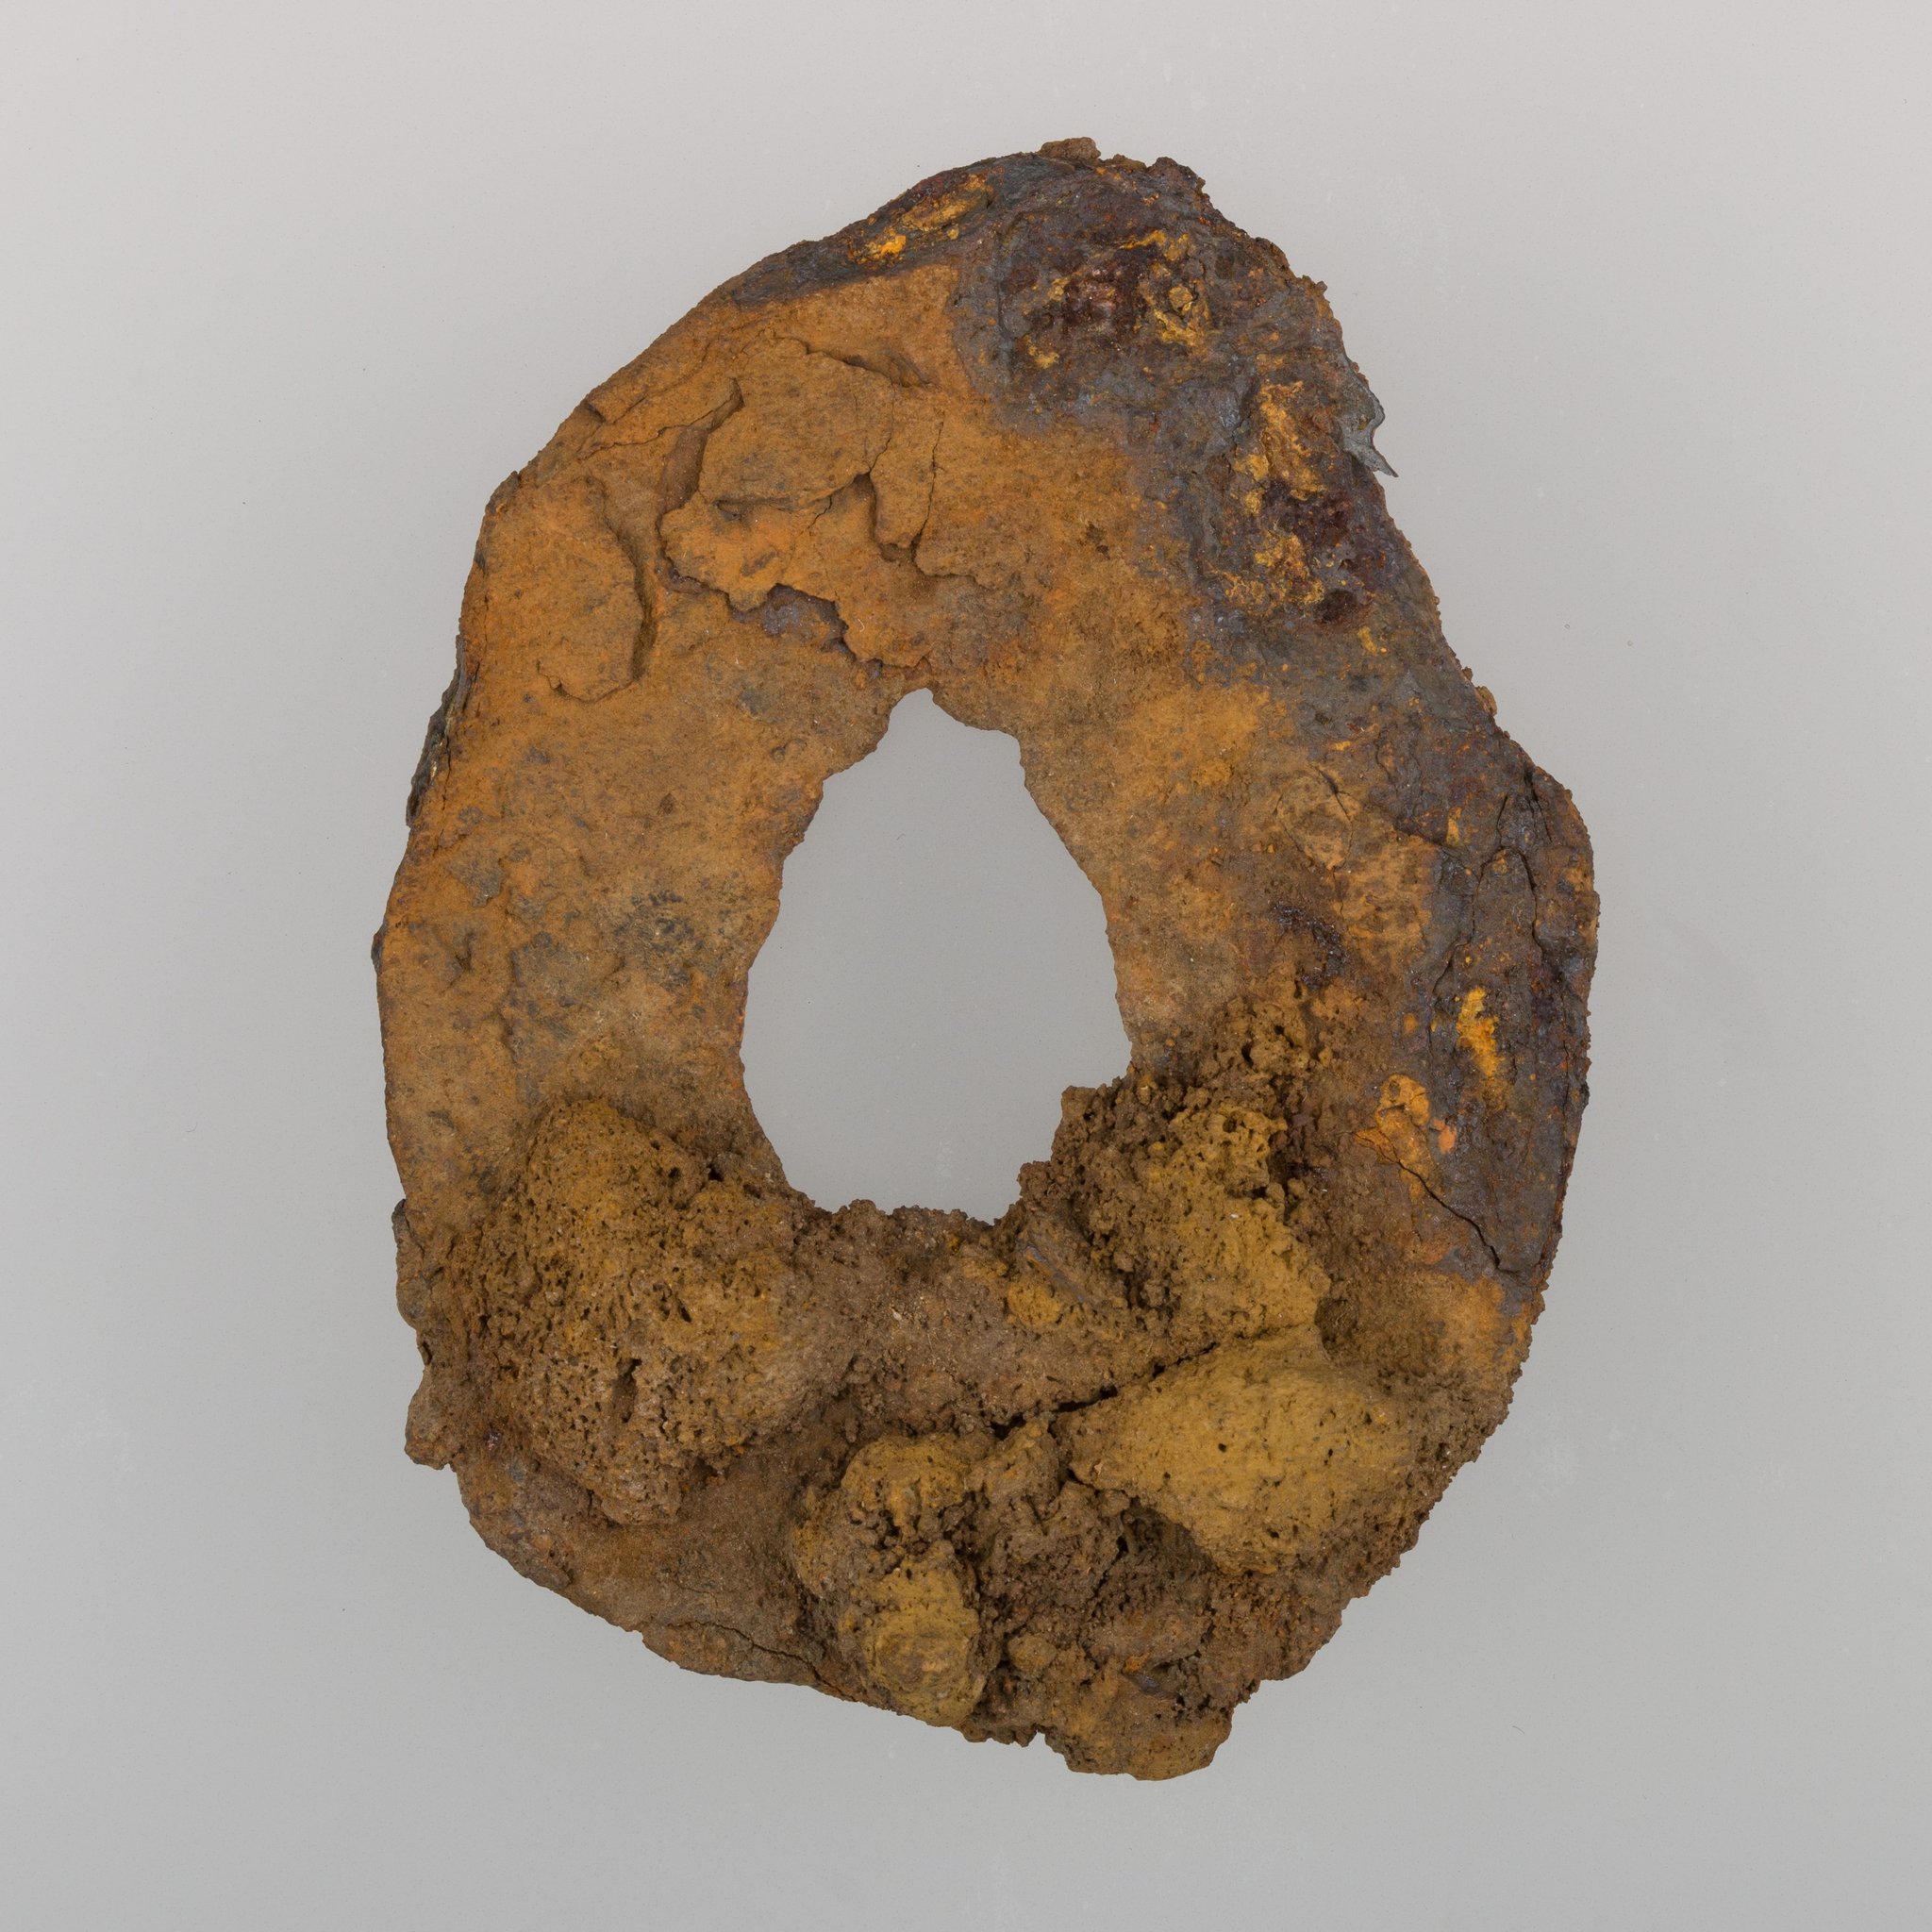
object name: sword guard tsuba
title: Sword Guard (Tsuba)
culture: japanese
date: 201-300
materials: iron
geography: japan